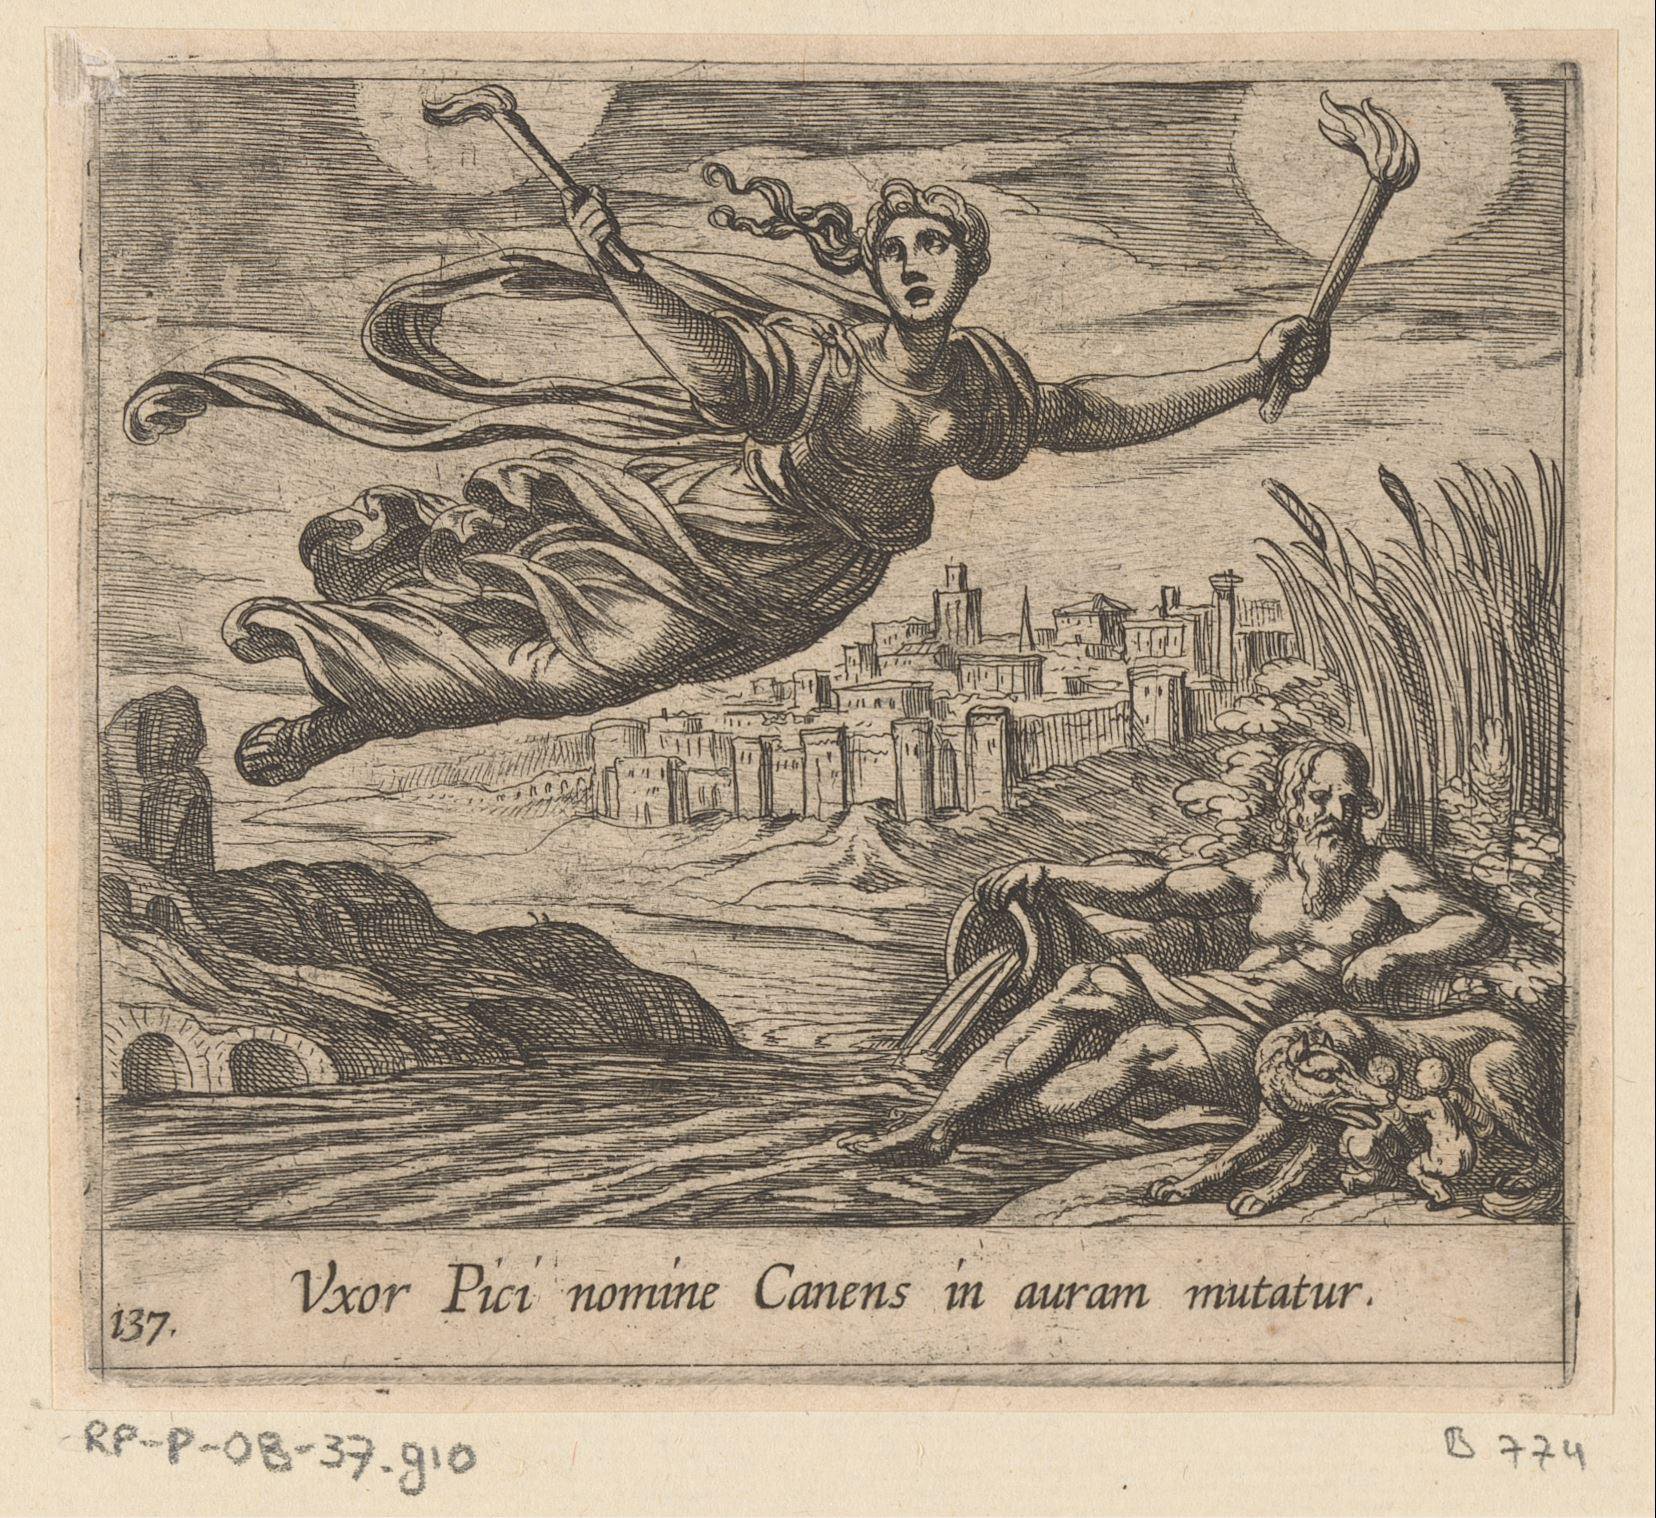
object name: print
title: Metamorphoseon sive transformationum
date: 1606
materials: paper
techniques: etching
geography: italy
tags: canens in search of picus, who on account of his spurning circe had been changed into a woodpecker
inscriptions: collector's mark: Lugt 240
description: Canens zweeft met twee fakkels boven een rivierlandschap zoekend naar Picus. Op de voorgrond rechts een riviergod (Tiber?) en de Lupa Capitolina die de tweeling Romulus en Remus zoogt. Titel in het Latijn in ondermarge.